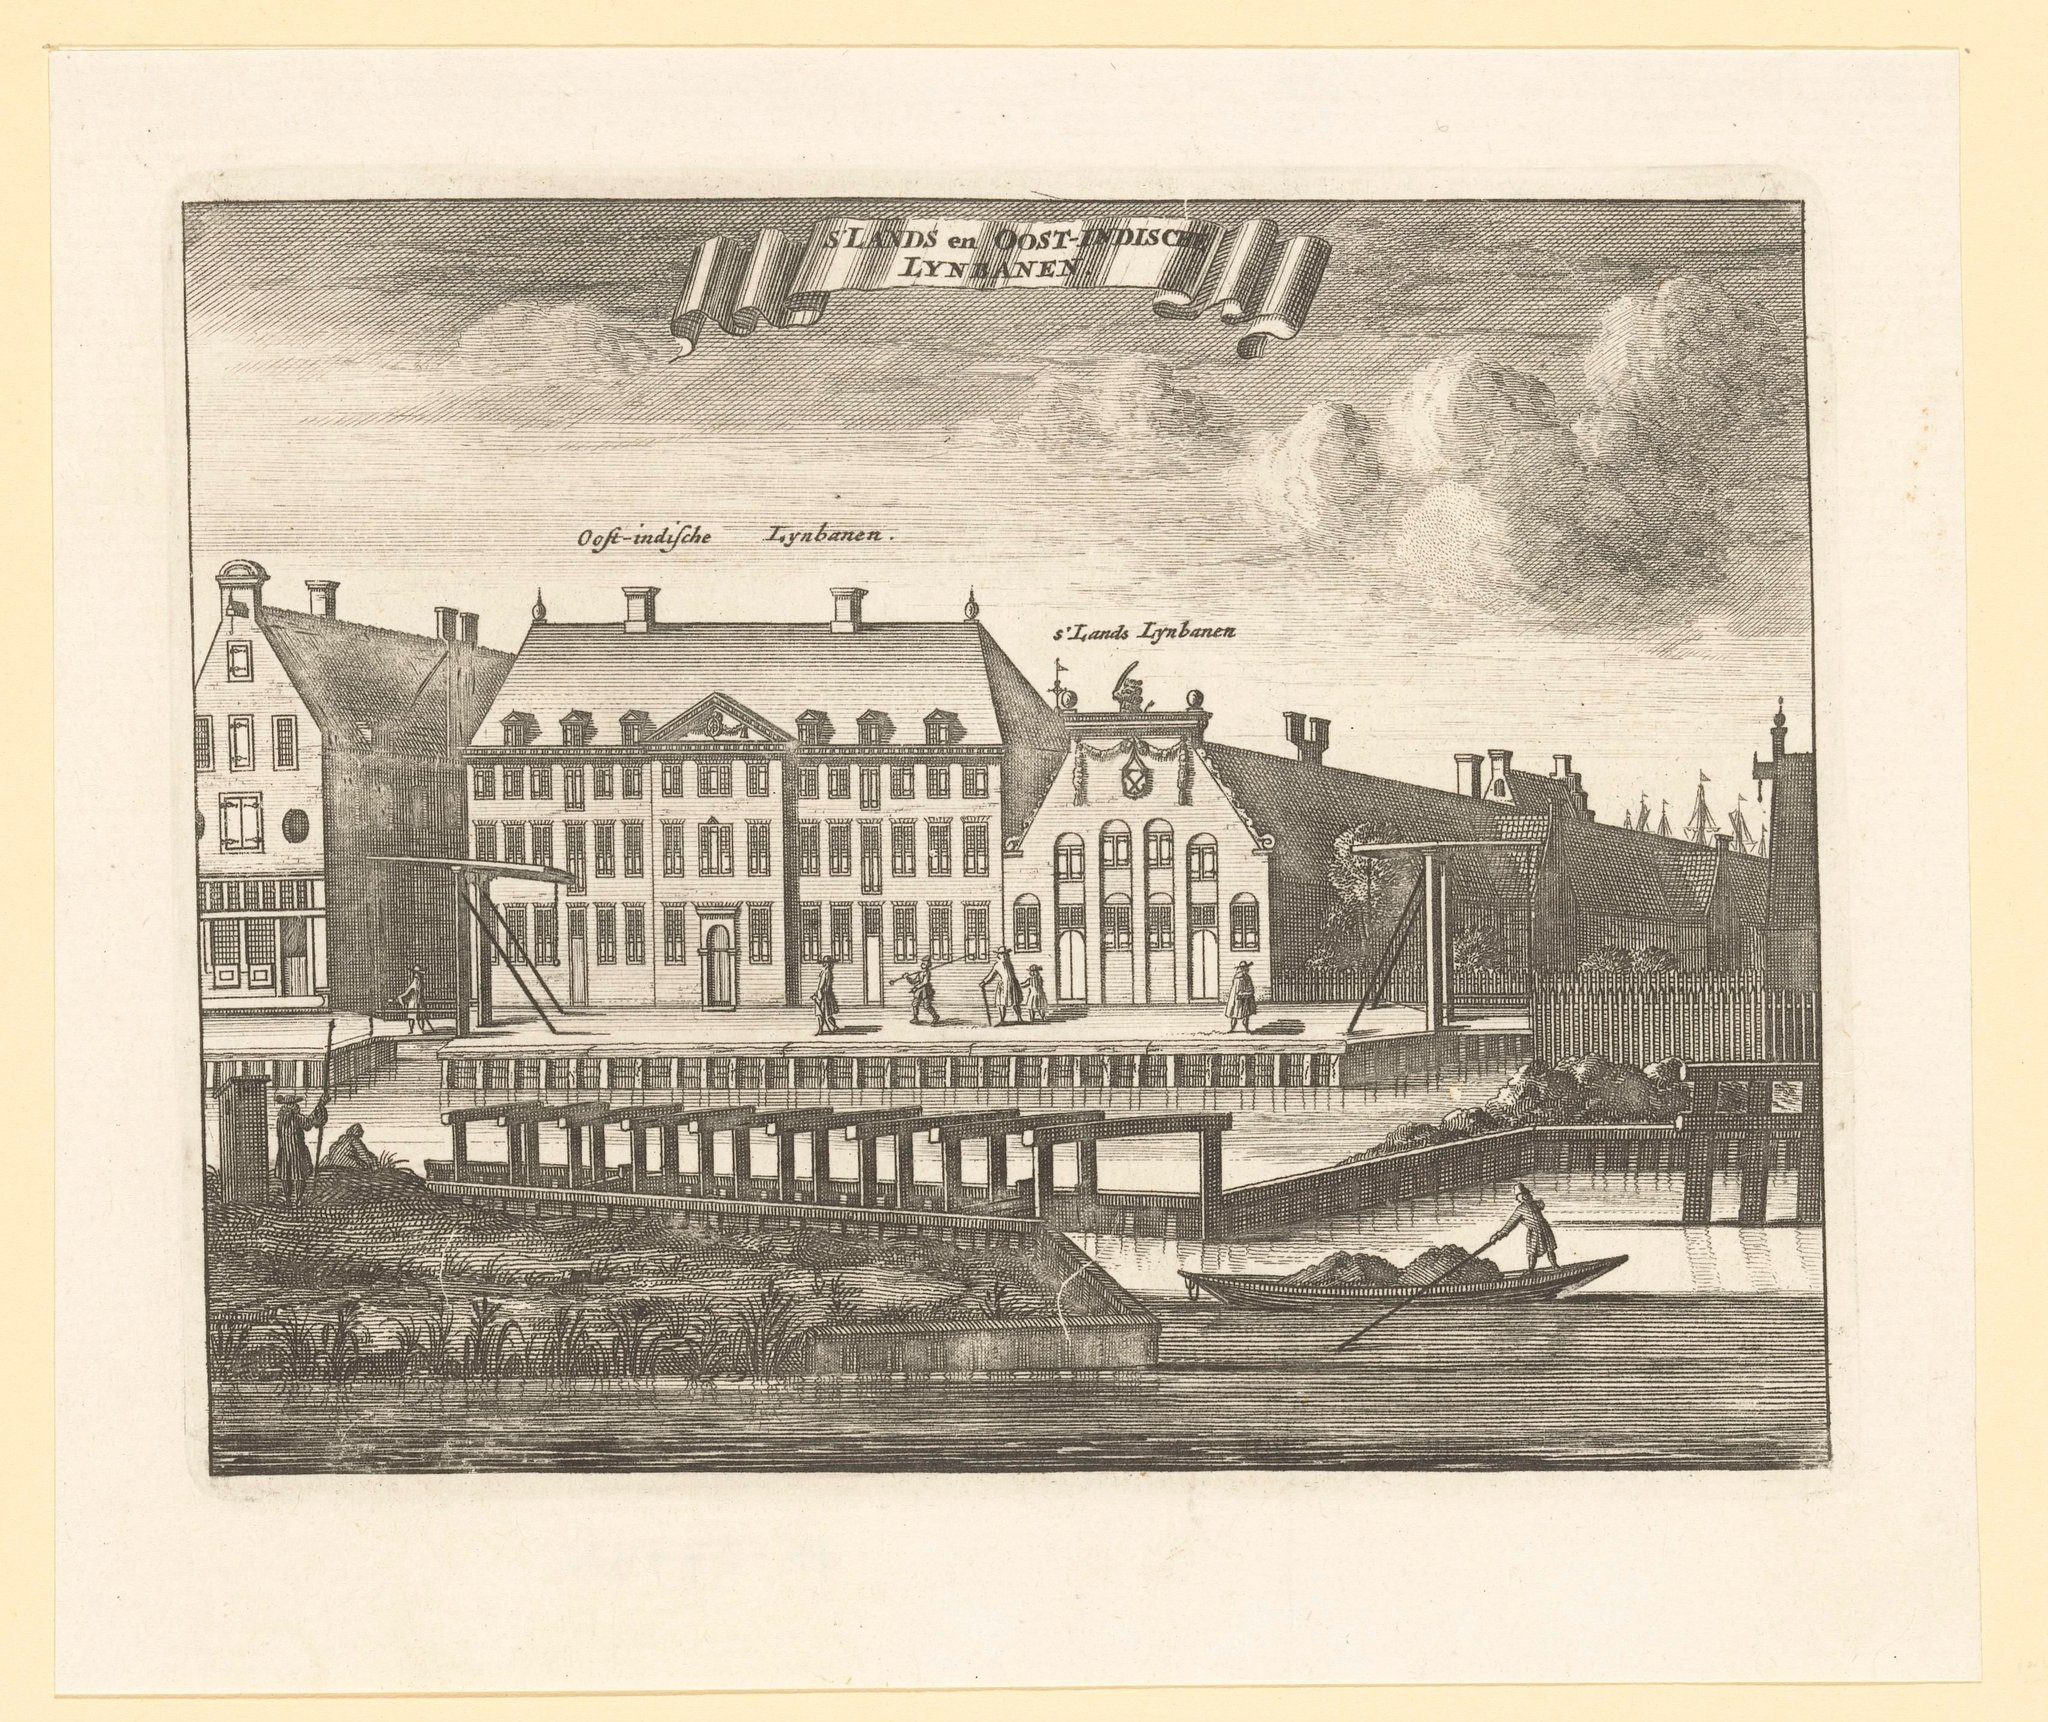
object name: book illustration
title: Gezicht op de lijnbanen van de VOC en de Admiraliteit op Oostenburg te Amsterdam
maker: Anonymous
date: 1693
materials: paper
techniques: engraving, etching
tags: ropery, rope-walk, canals, waters (in city) (+ city(-scape) with figures, staffage), street (+ city(-scape) with figures, staffage)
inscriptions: collector's mark: Lugt 2228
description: Huidige staat van prent ook gebruikt in: Commelin, Caspar. Beschryvinge van Amsterdam, zynde een naukeurige verhandelinge van desselfs eerste oorspronk uyt (…). 2 delen. 2e druk. Amsterdam: Andries van Damme, Johannes Ratelband, weduwe A. van Aaltwyk en Hermanus Uytwerf, 1726. Eerdere staat van prent (RP-P-AO-25-60-1) ook gebruikt in: Commelin, Caspar. Beschryvinge van Amsterdam, desselfs eerste oorspronk uyt den Huyse (…). 2 delen. Amsterdam: Abraham Wolfgang, Gillis Janssonius van Waesberge, Johannes Janssonius van Waesberge II, weduwe Dirk Boom I, Hendrick Boom en Rembertus Goethals, 1693. En in: Commelin, Caspar. Beschryvinge van Amsterdam, zynde een naukeurige verhandelinge van desselfs eerste oorspronk uyt (…). 2 delen. Amsterdam: weduwe Aart Dircksz Oossaan, 1694.